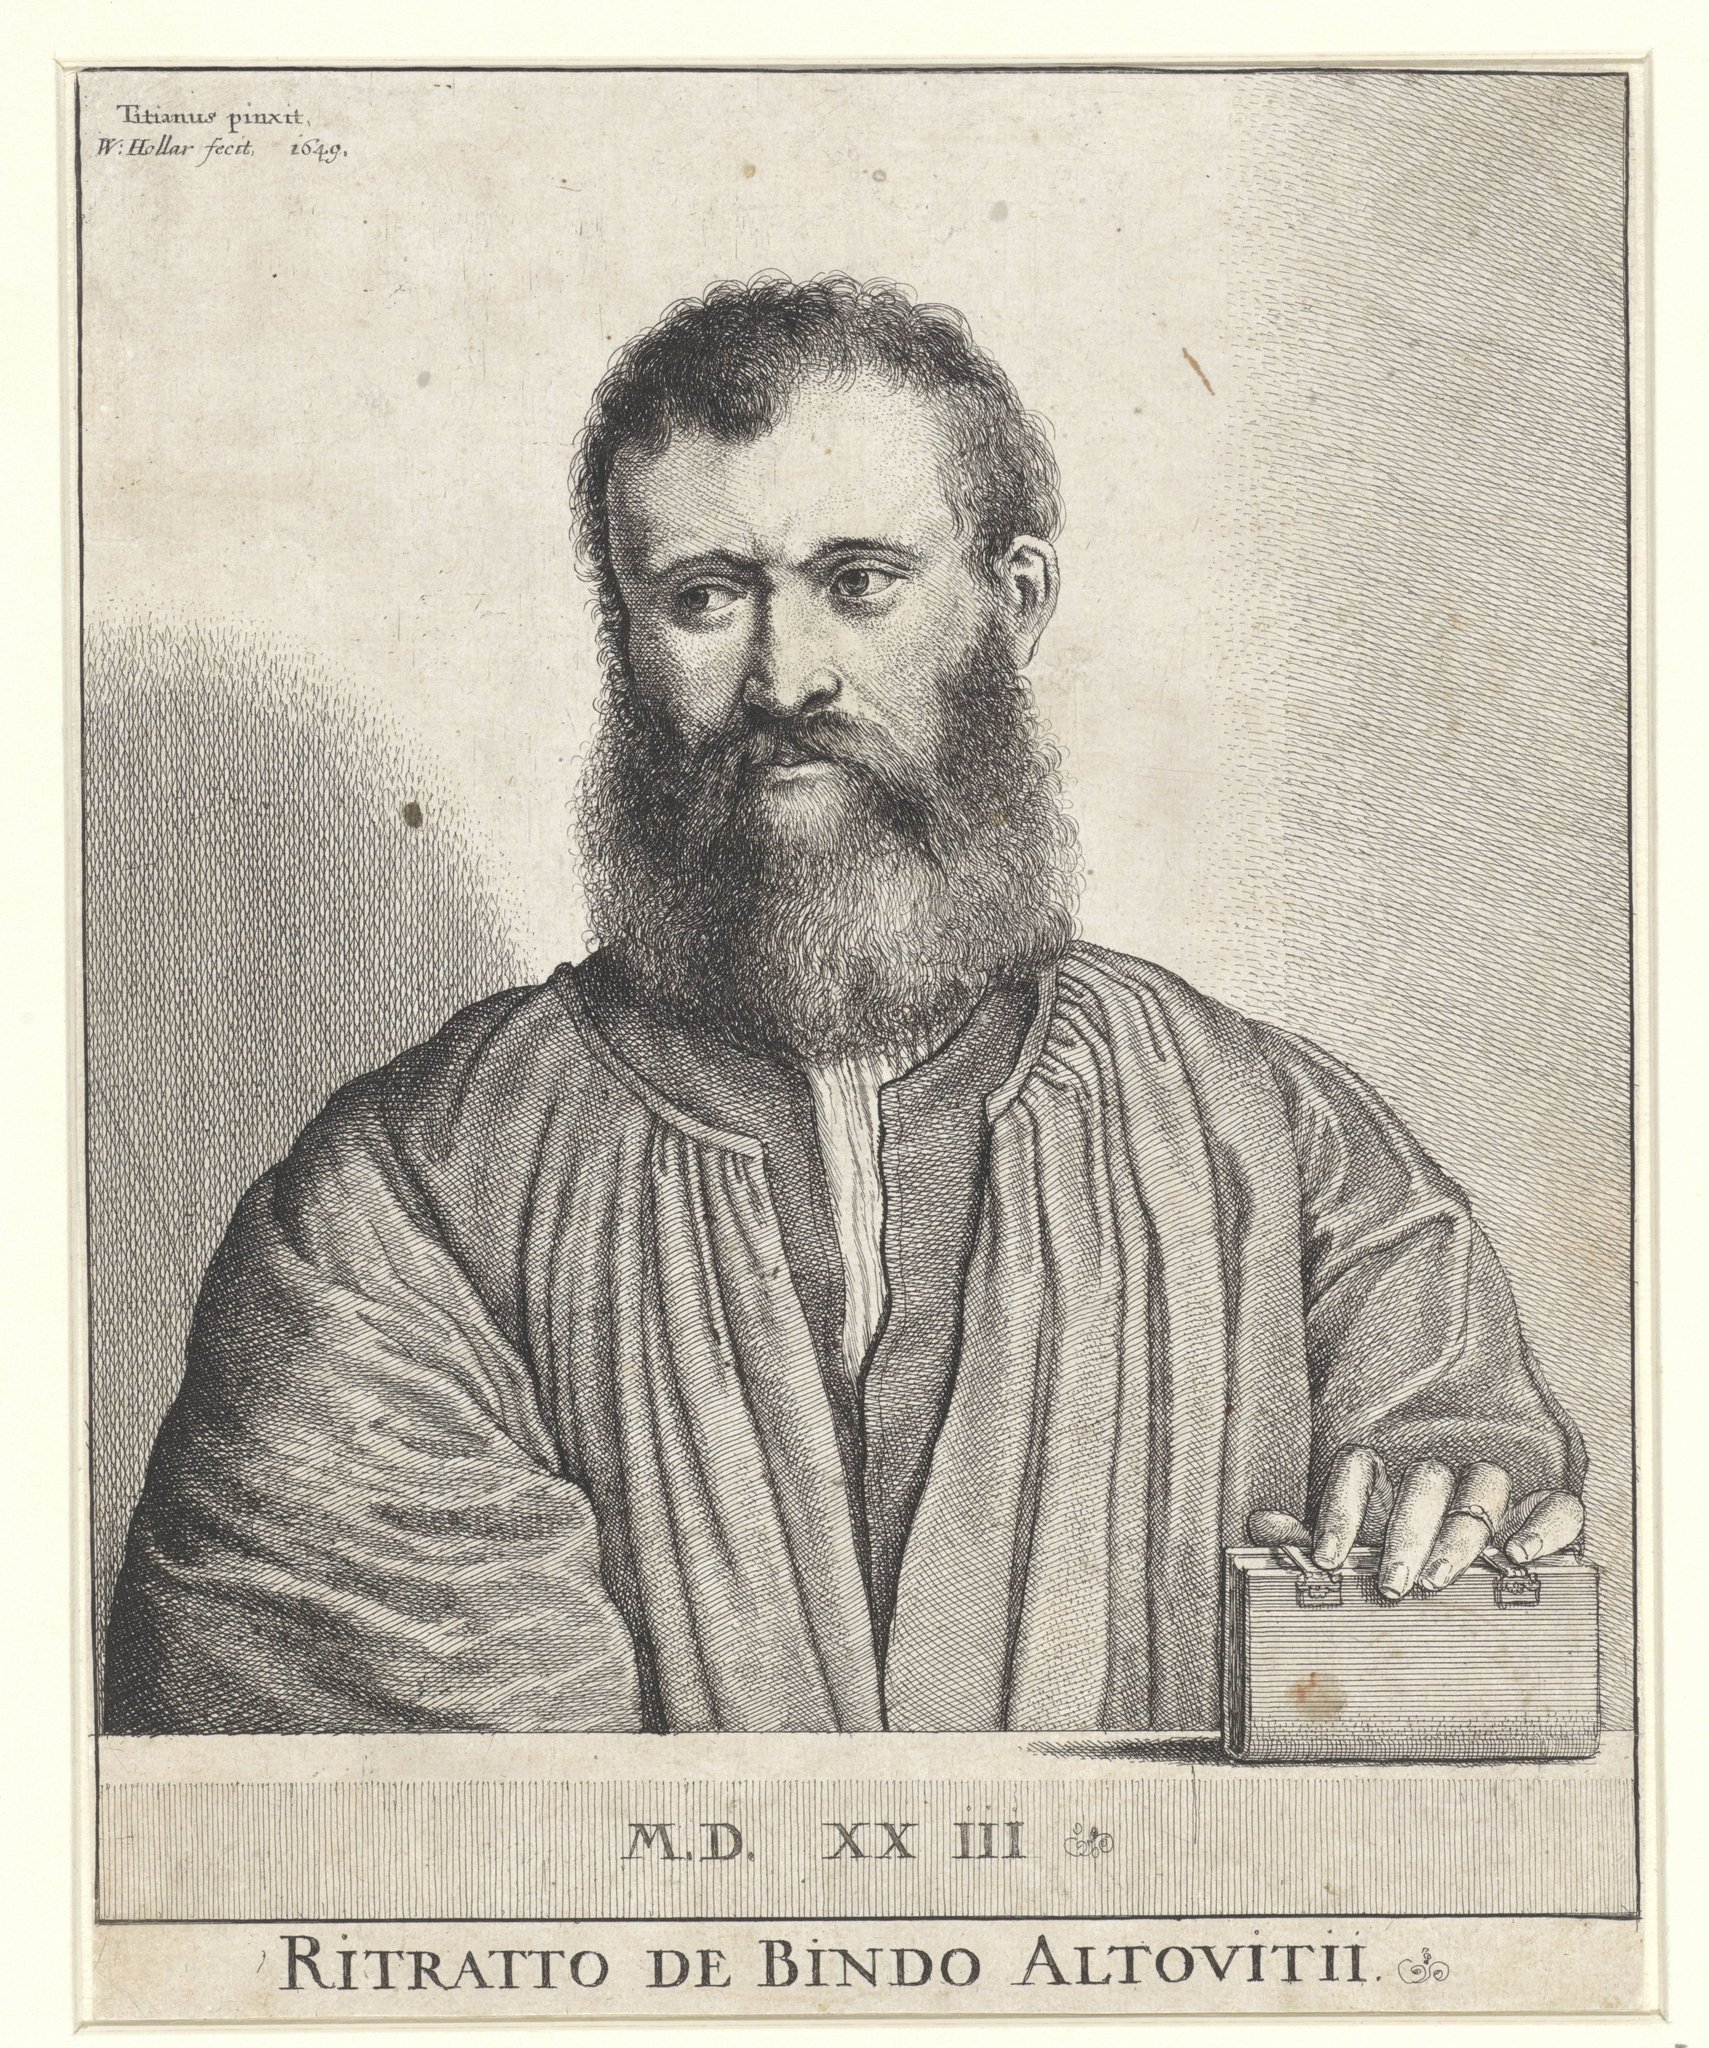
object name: print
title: Portret van Bindo Altoviti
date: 1649-1651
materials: paper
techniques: etching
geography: antwerp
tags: verzamelaar, bindo altoviti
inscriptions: collector's mark: Lugt 240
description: De prent maakt deel uit van een tiendelige serie met Italiaanse portretten (ongenummerd).